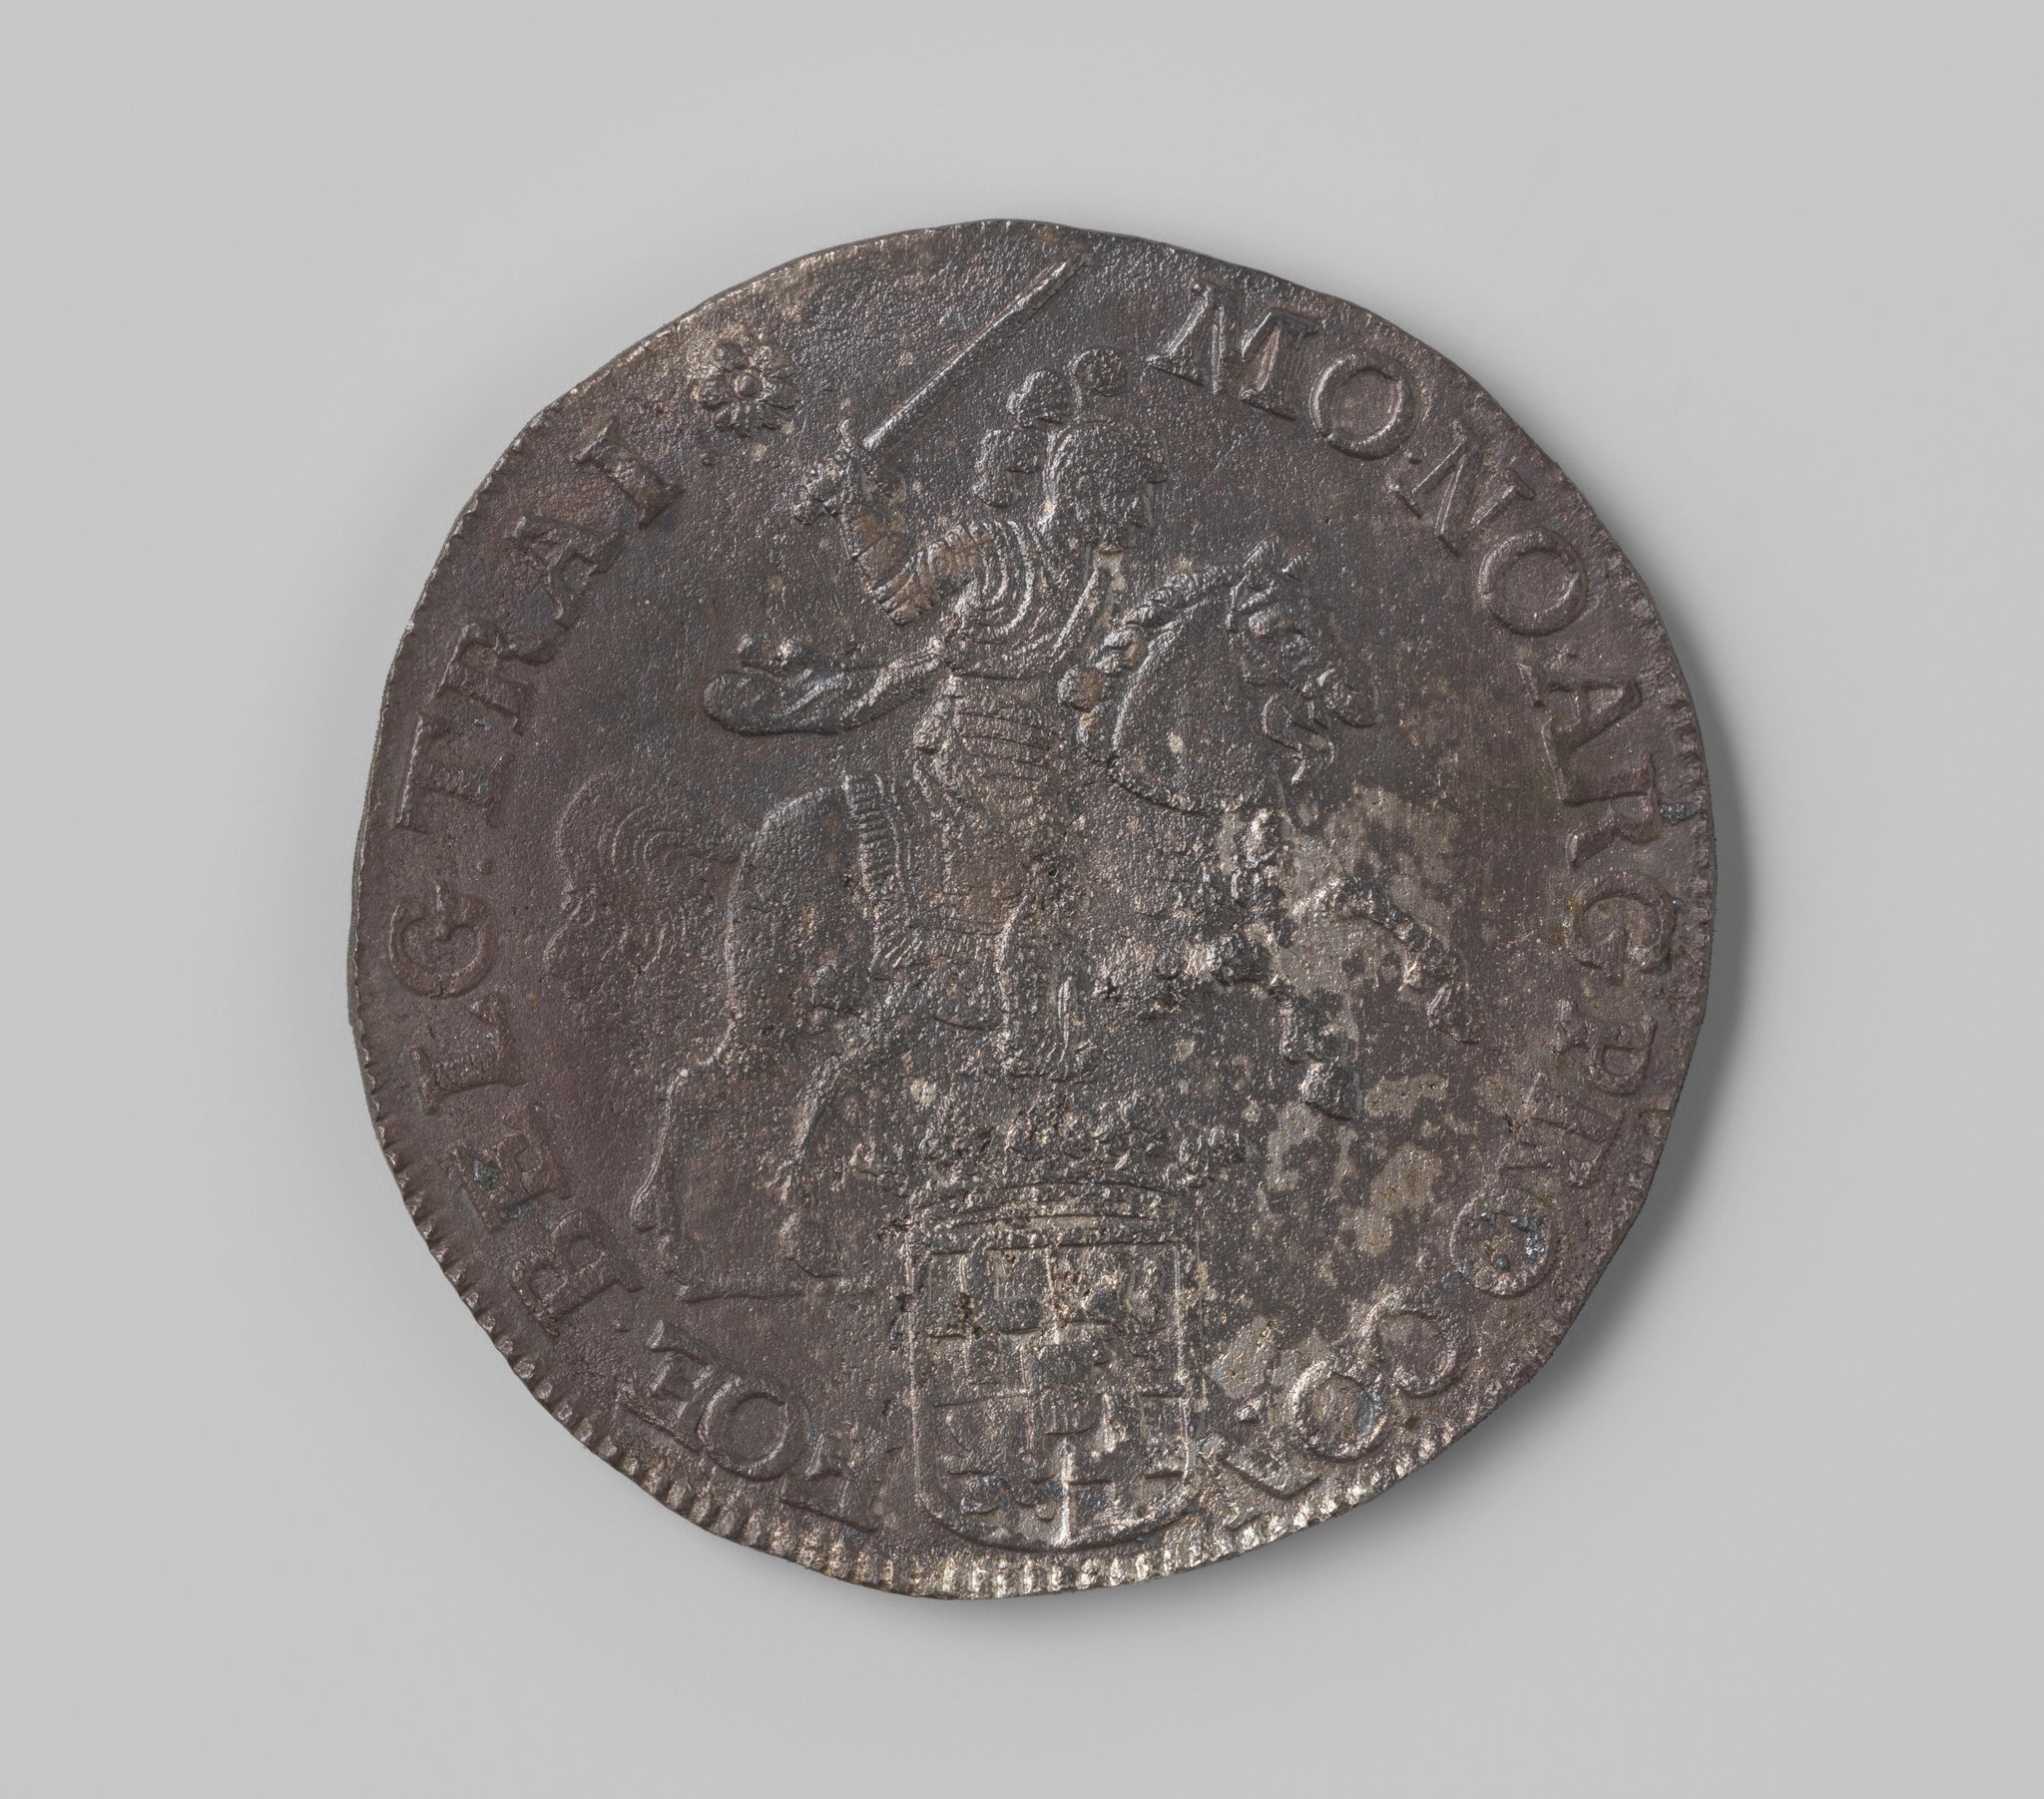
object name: coin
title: Zilveren rijder uit het wrak van de Oost-Indiëvaarder Liefde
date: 1711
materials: silver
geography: utrecht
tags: england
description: Zilveren rijder. Zilveren ronde munt afkomstig uit het wrak van de Oost-Indiëvaarder Liefde. De munt is in 1711 in Utrecht geslagen.